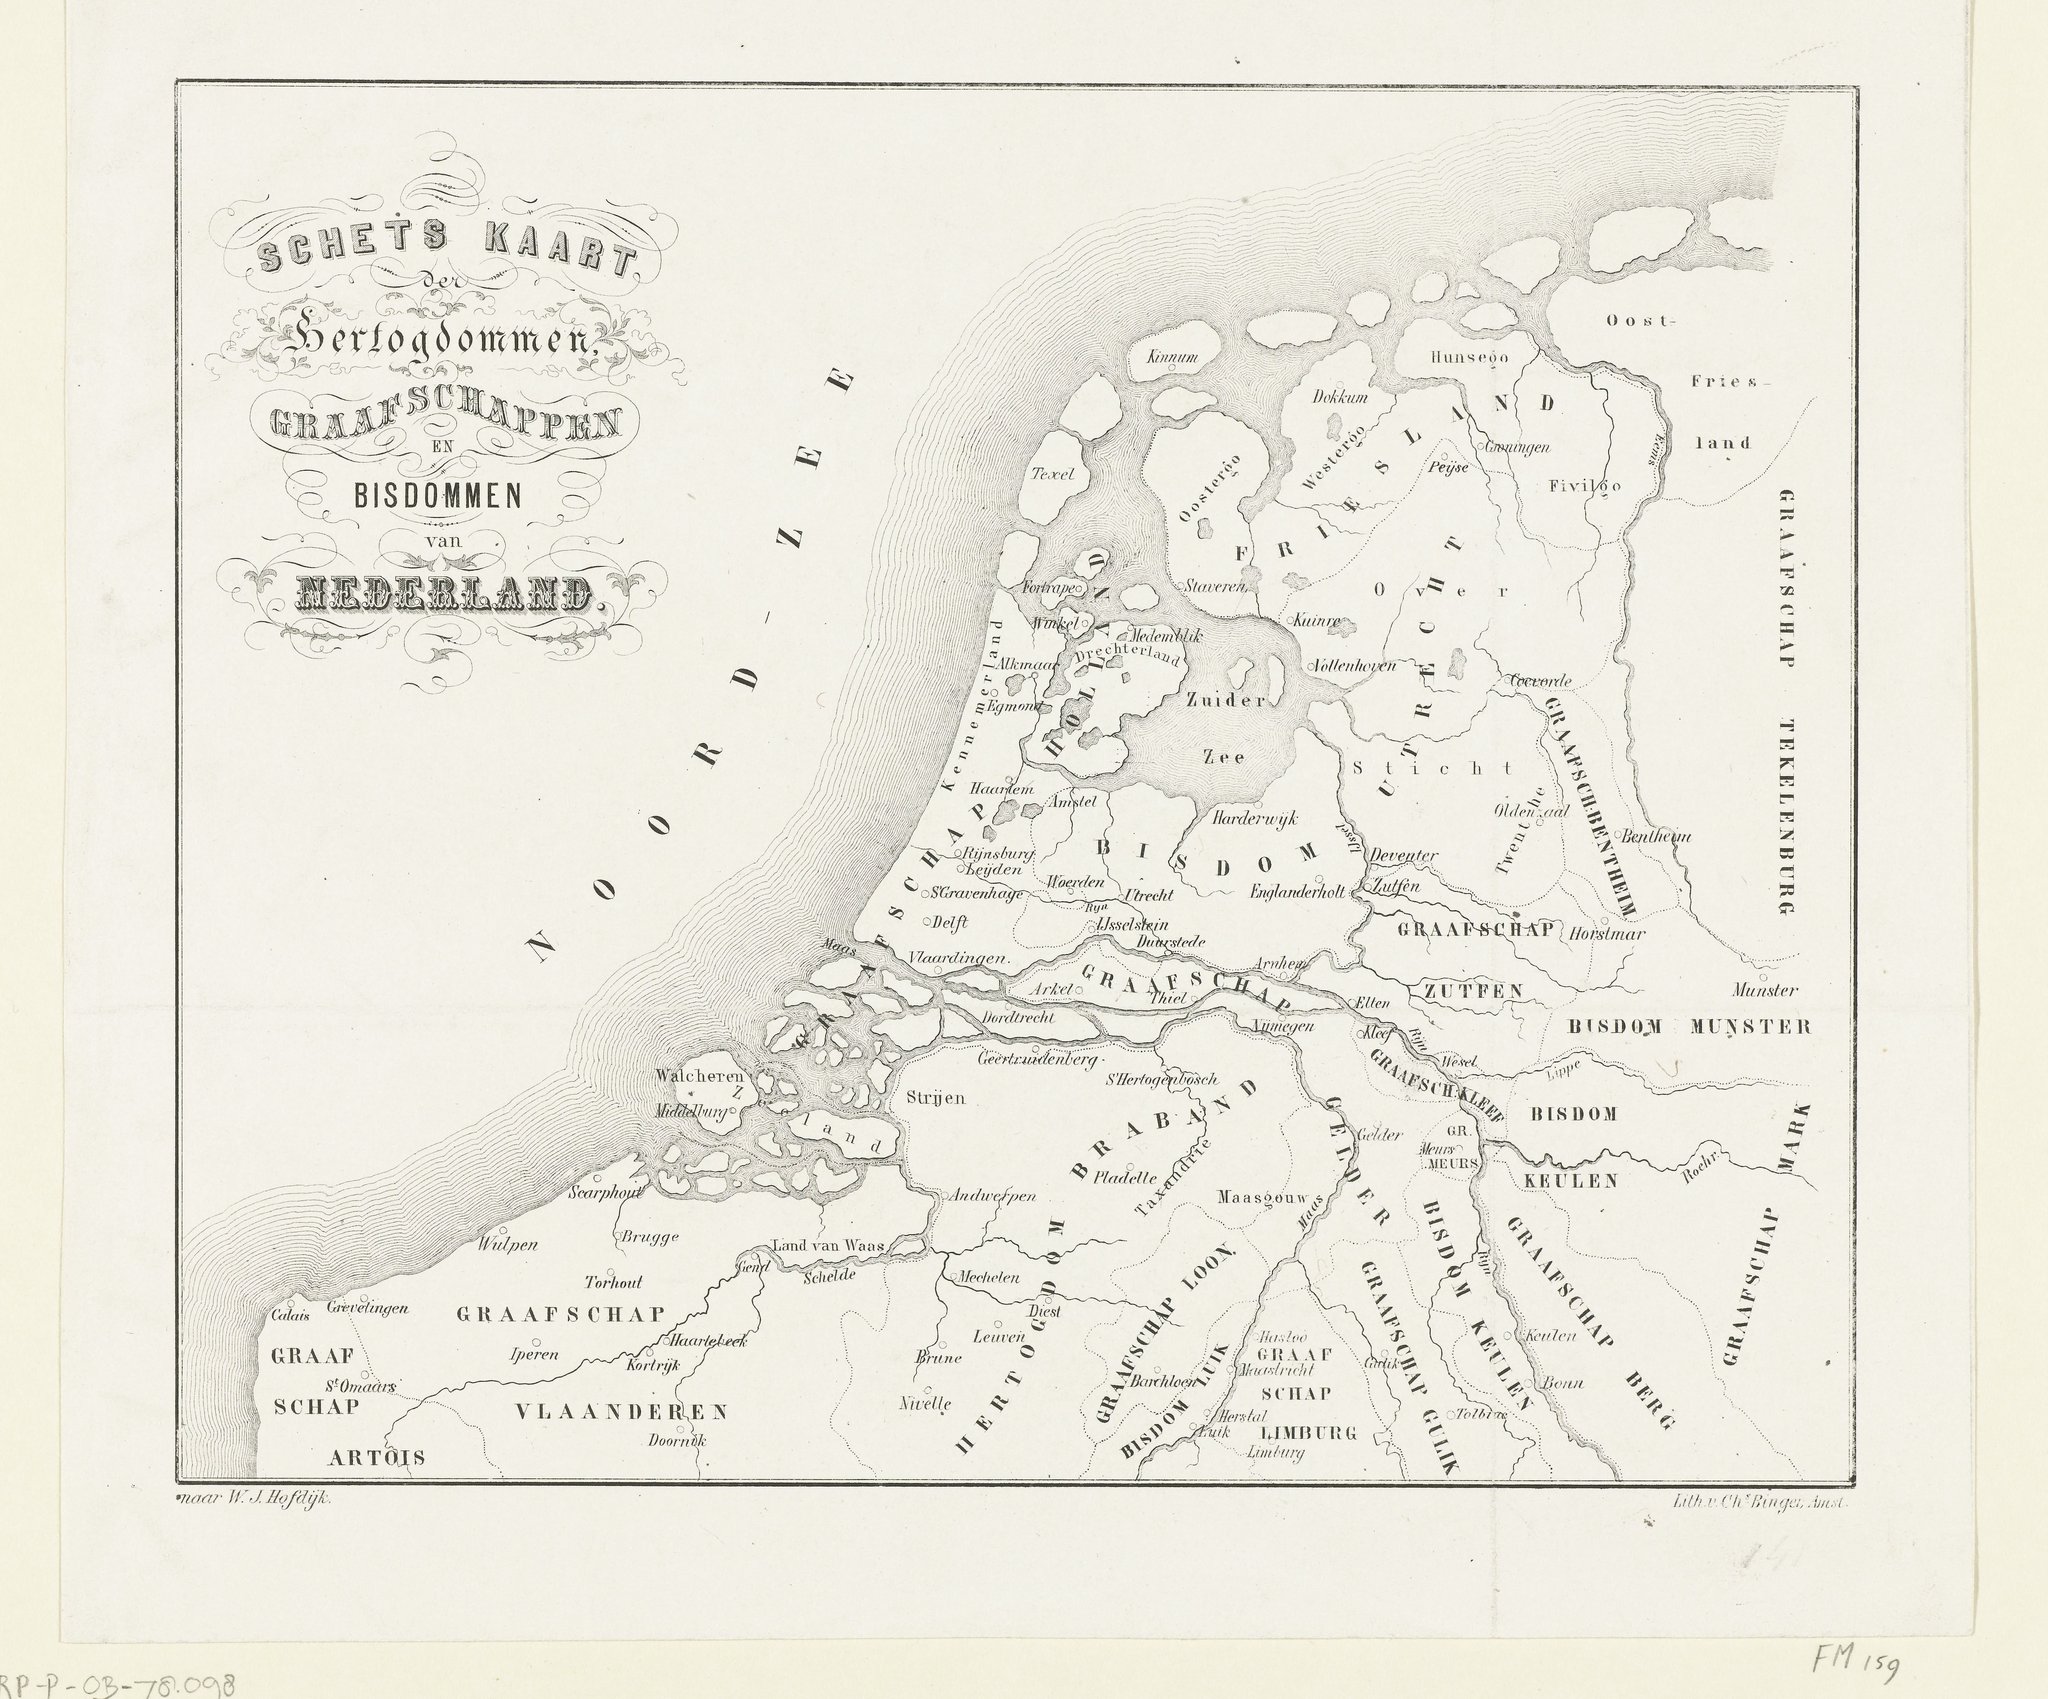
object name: map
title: Schets kaart der hertogdommen, graafschappen en bisdommen van Nederland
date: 1853-1861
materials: paper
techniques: lithograph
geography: netherlands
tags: maps of separate countries or regions, netherlands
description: Illustratie voor: Jacob van Lennep, De geschiedenis des vaderlands in schetsen en afbeeldingen, Binger, Amsterdam 1855-1861, 8 delen, pl. IX.